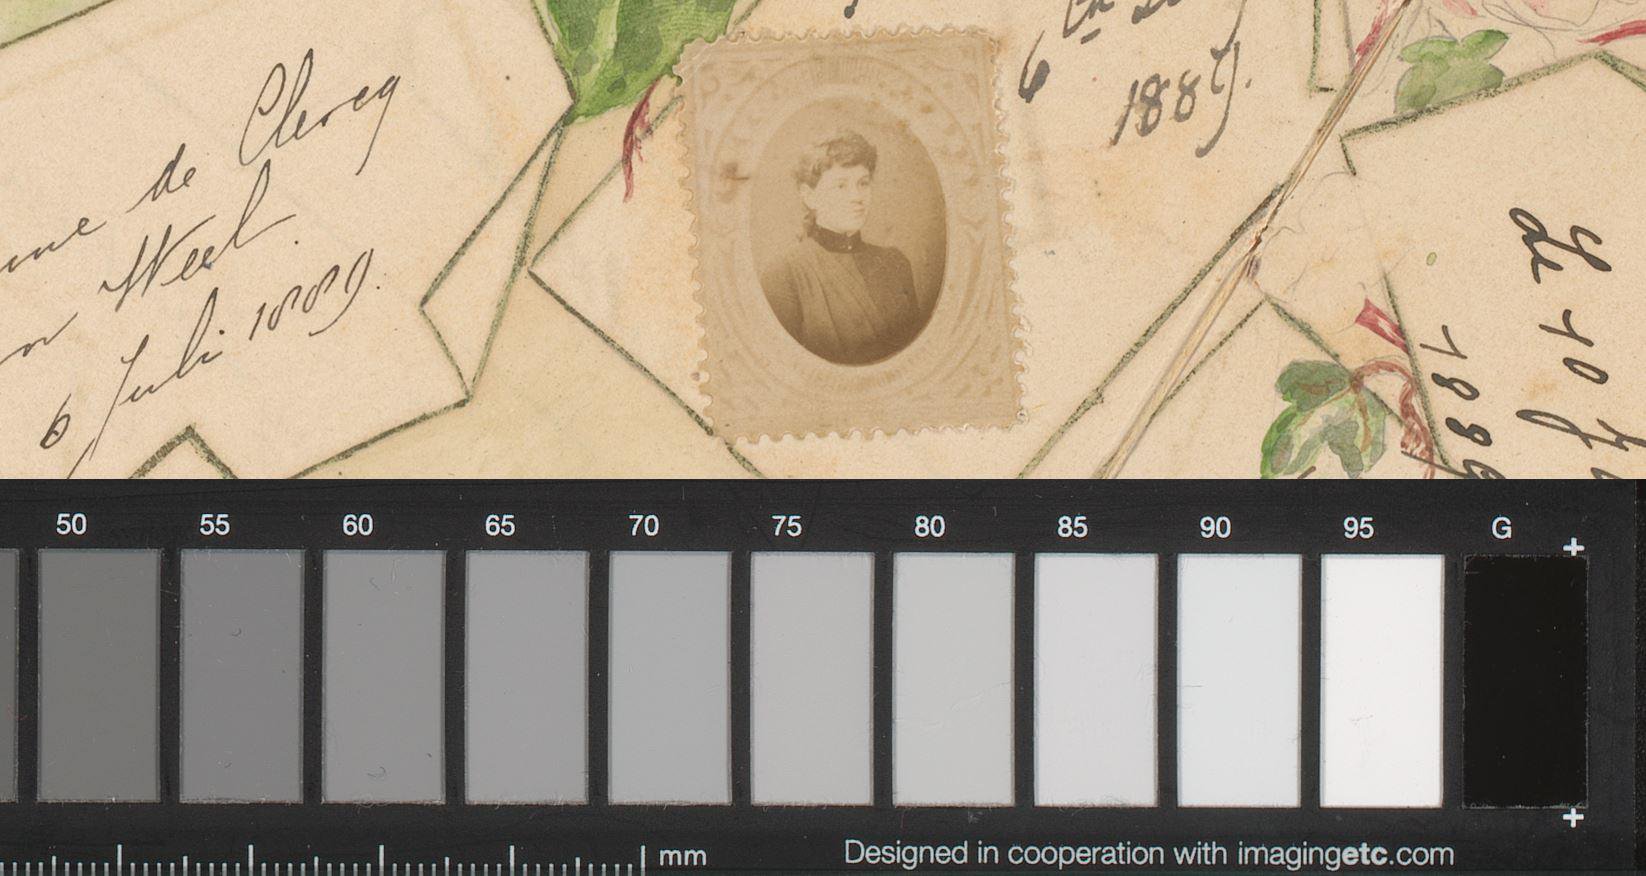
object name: album leaf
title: Miniatuurportret van een jonge vrouw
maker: Anonymous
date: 1880-1890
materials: photographic support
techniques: albumen print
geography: netherlands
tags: adolescent, young woman, maiden, historical persons - bb - woman